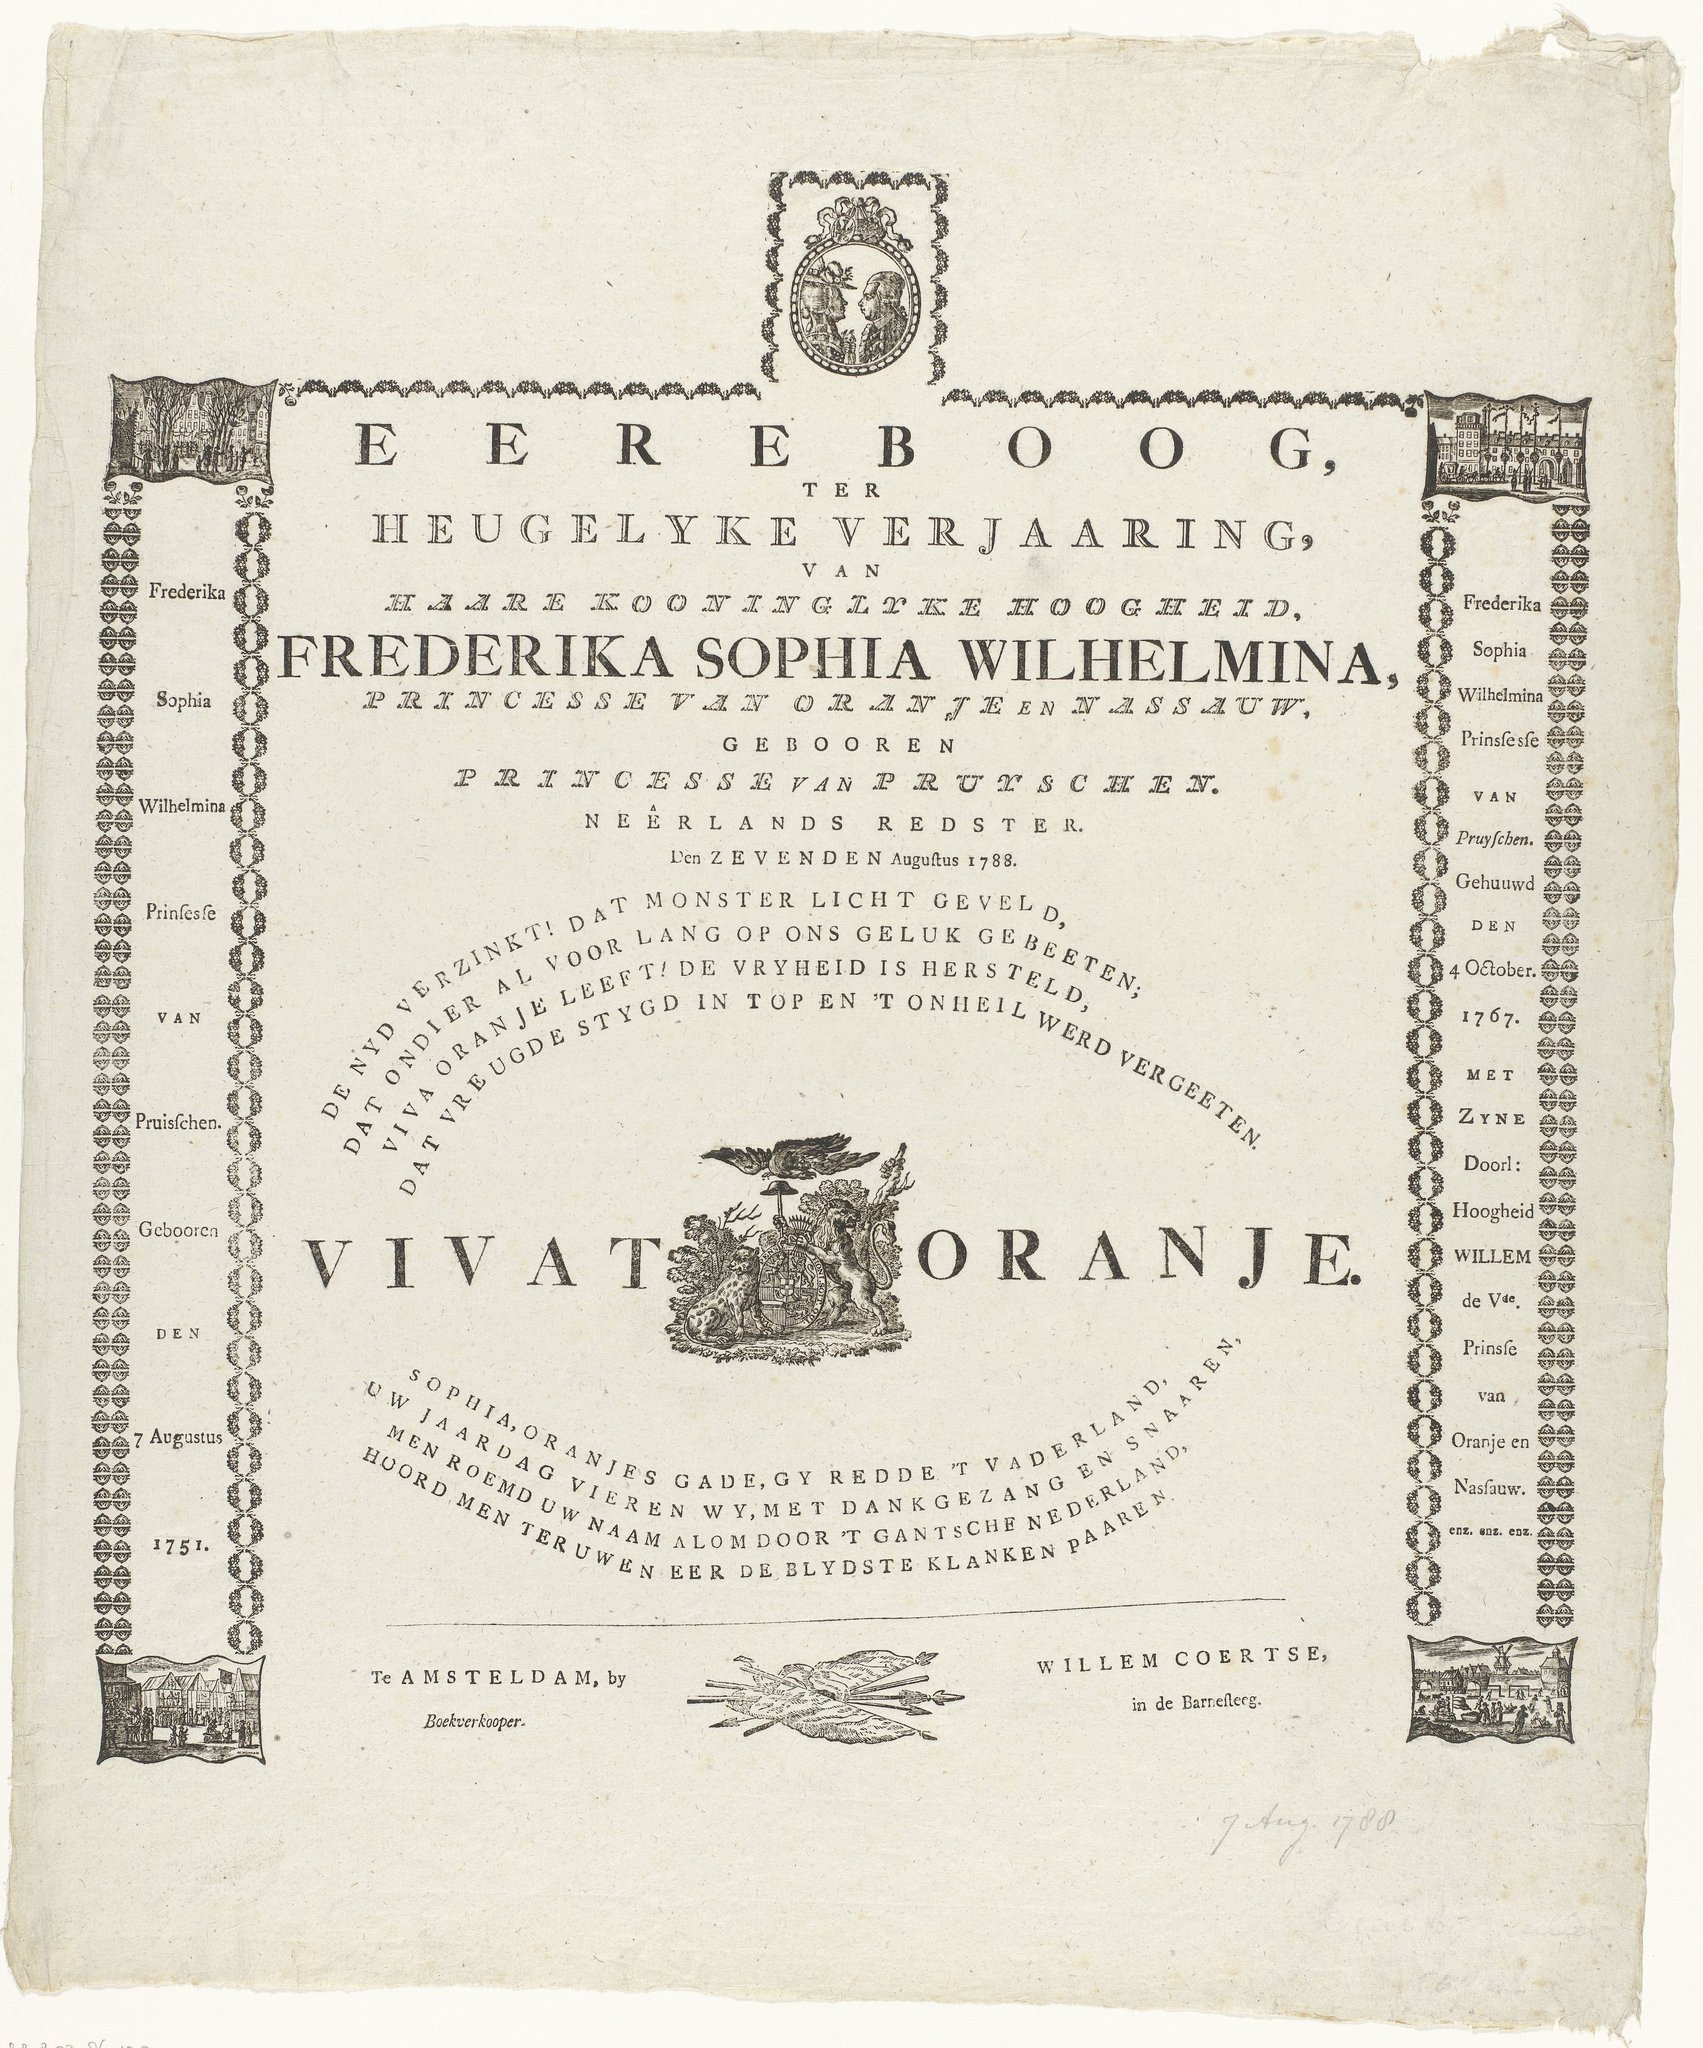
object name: print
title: Typografische ereboog bij de verjaardag van prinses Wilhelmina van Pruisen op 7 augustus 1788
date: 1788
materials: paper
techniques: letterpress printing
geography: northern netherlands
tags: william v (prince of orange), berlin, painter, draughtsman, wilhelmina of prussia (princess of orange)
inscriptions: collector's mark: Lugt 2228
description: Typografische ereboog ter gelegenheid van de verjaardag van prinses Wilhelmina van Pruisen op 7 augustus 1788. In de vier hoeken kleine vignetten met feestelijke activiteiten, bovenaan een medaillon met de prins en prinses van Oranje. Centraal een achtregelig vers om een vignet met de Nederlandse leeuw, Pruisische adelaar en Engelse panter (Triple Alliantie).